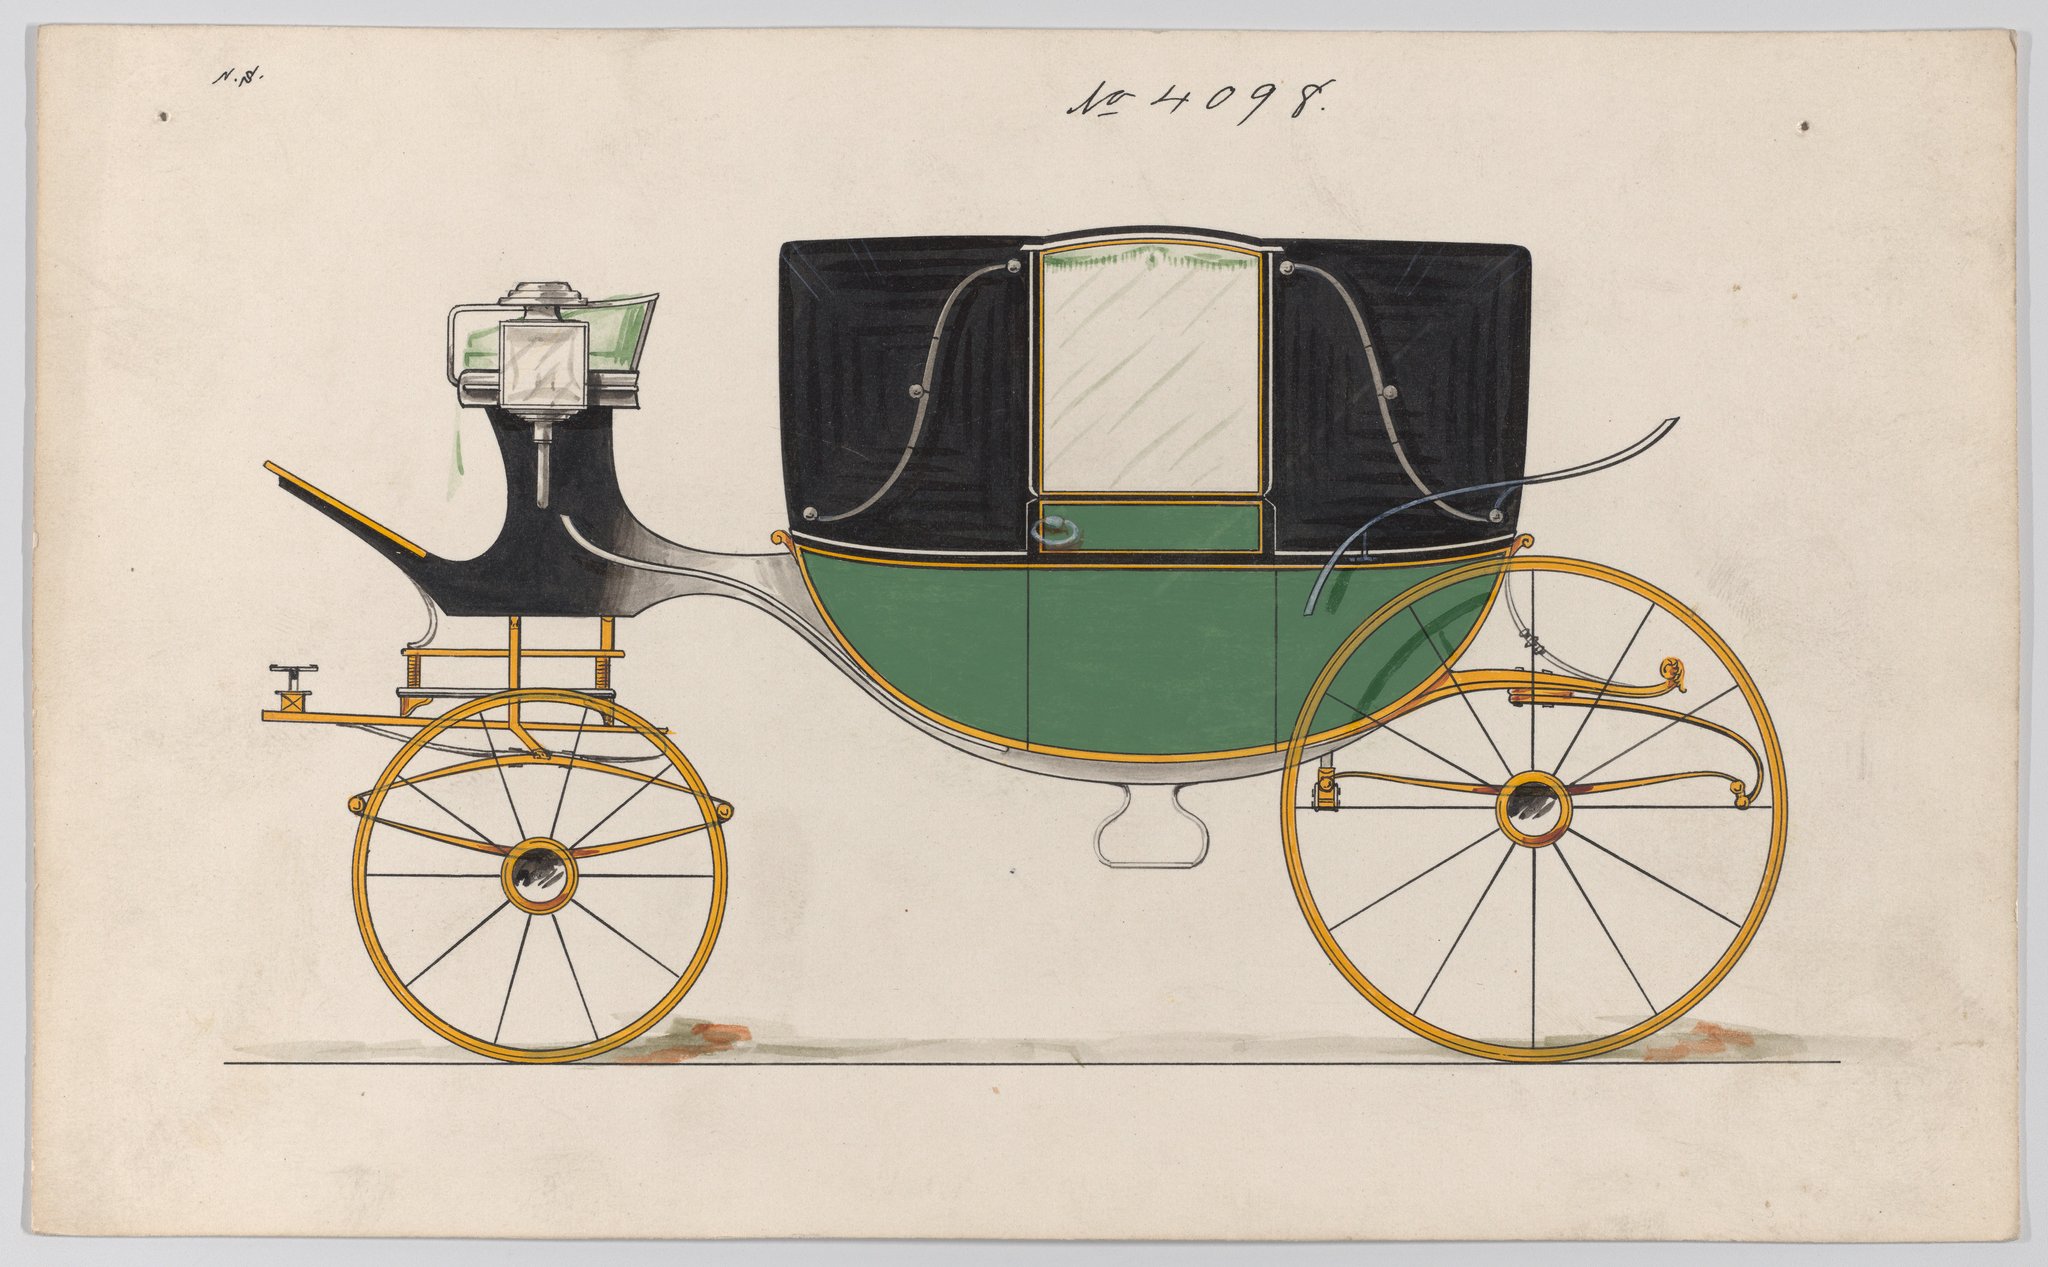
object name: drawing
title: Design for Landau, No. 4098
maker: brewster & co.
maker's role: manufacturer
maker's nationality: american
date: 1890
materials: gouache, gum arabic, ink, watercolor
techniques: pen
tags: carriages